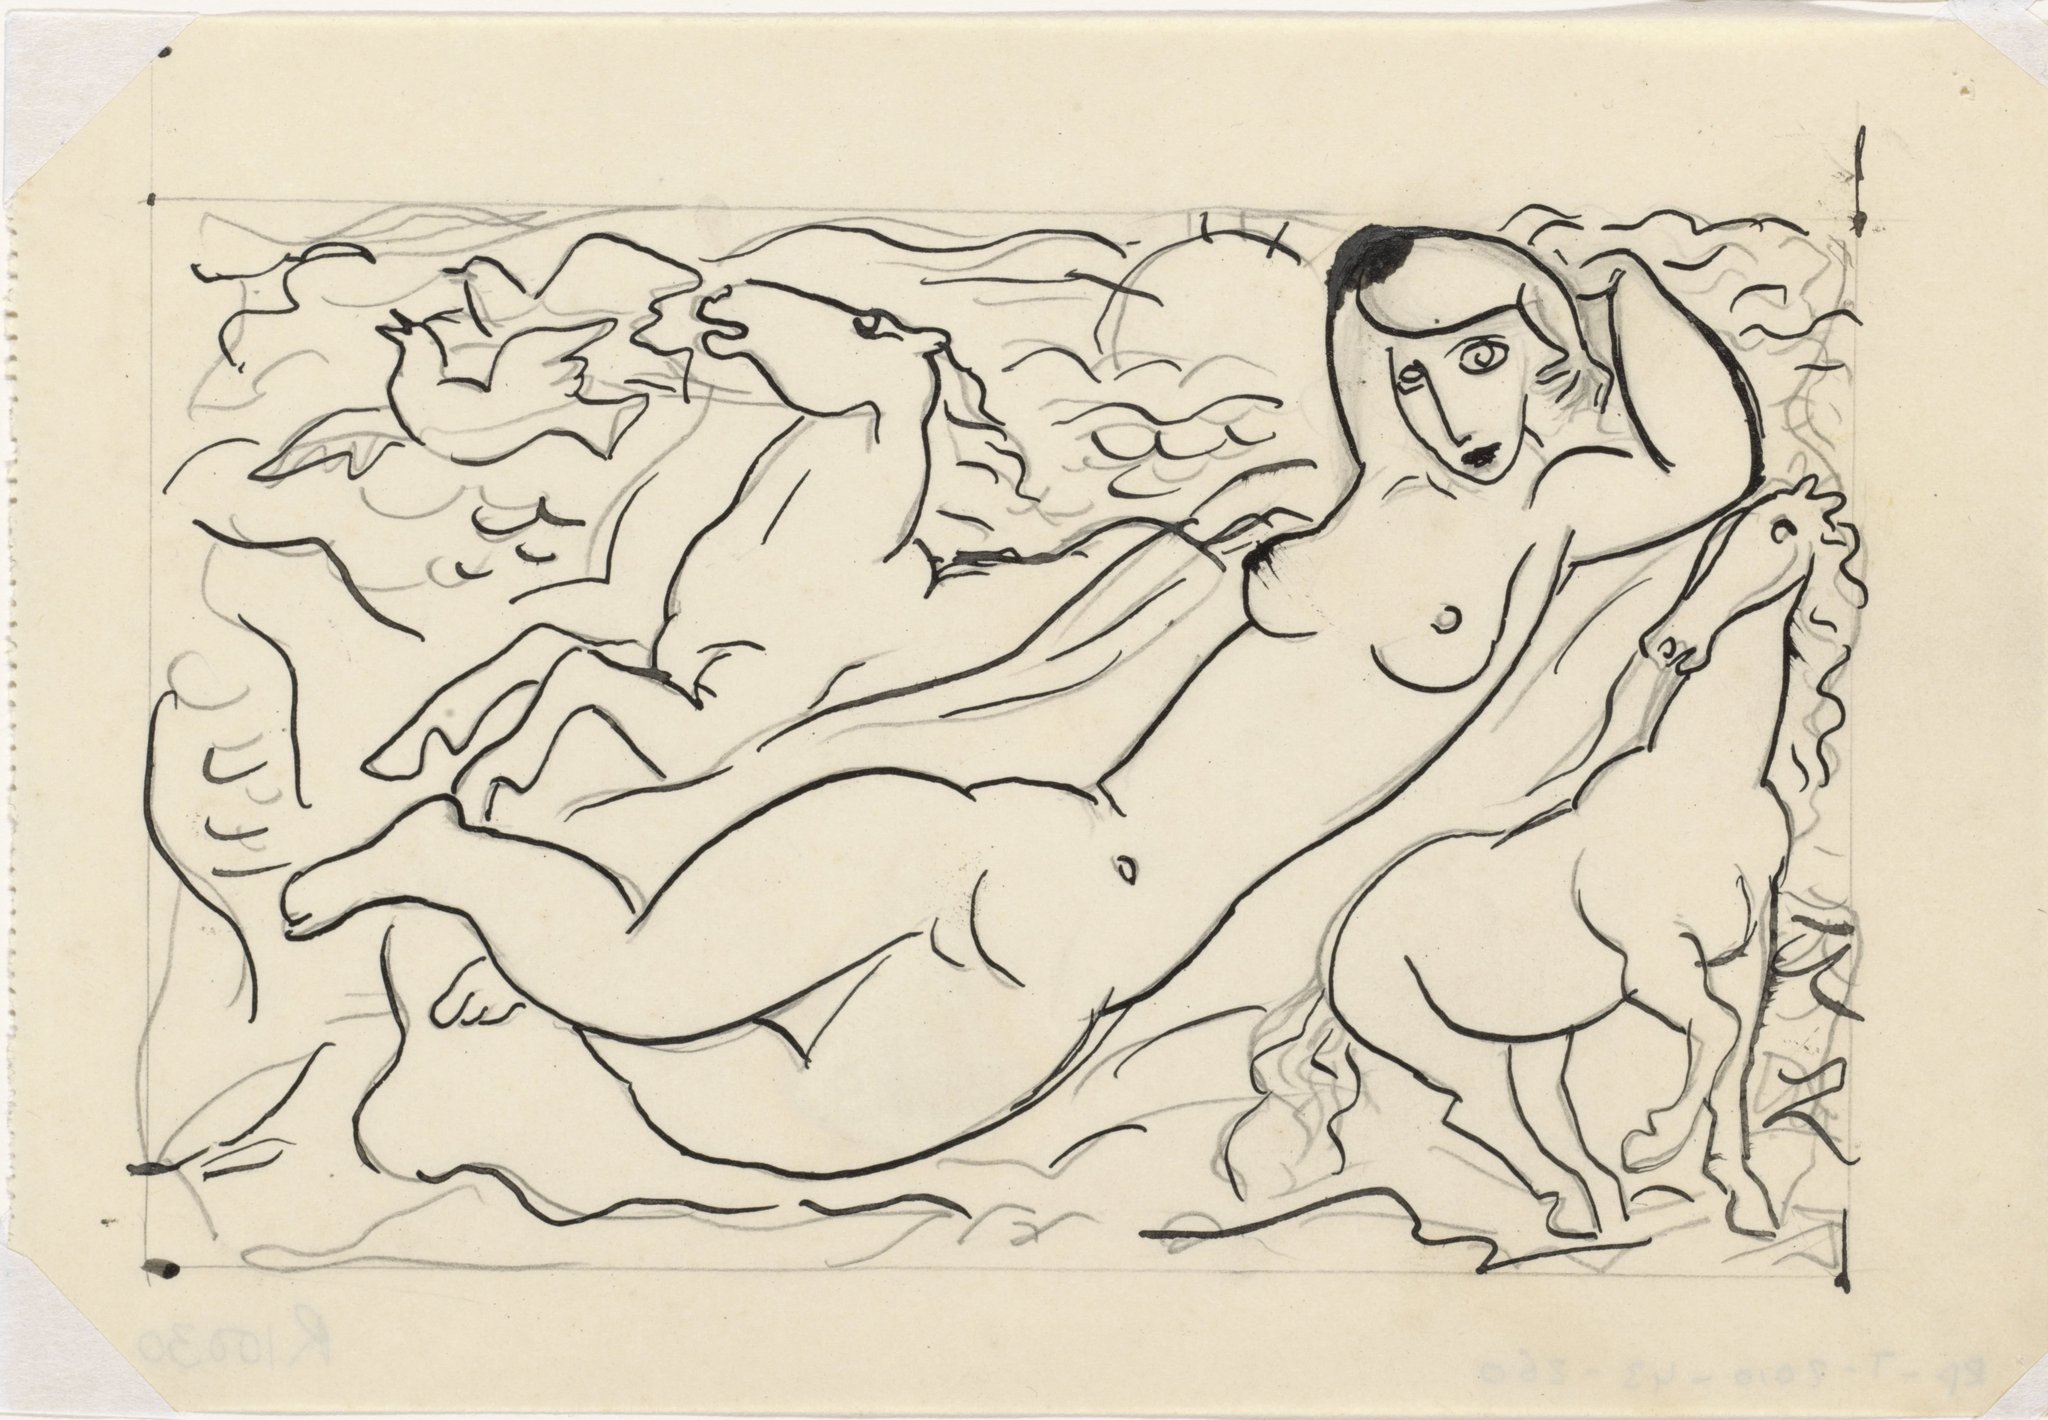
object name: drawing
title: Venus Vignet voor boek 'L'art Hollandais contemporain' van Paul Fierens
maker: leo gestel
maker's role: draughtsman, print maker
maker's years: 1881-1941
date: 1932-1933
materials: ink, paper, pencil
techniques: pen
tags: horse, lying figure - aa - female human figure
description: Venus Vignet voor boek 'L'art Hollandais contemporain' van Paul Fierens; liggend naakt in de golven met daarbij afgebeeld twee paarden en twee duiven, bij een opkomende zon.